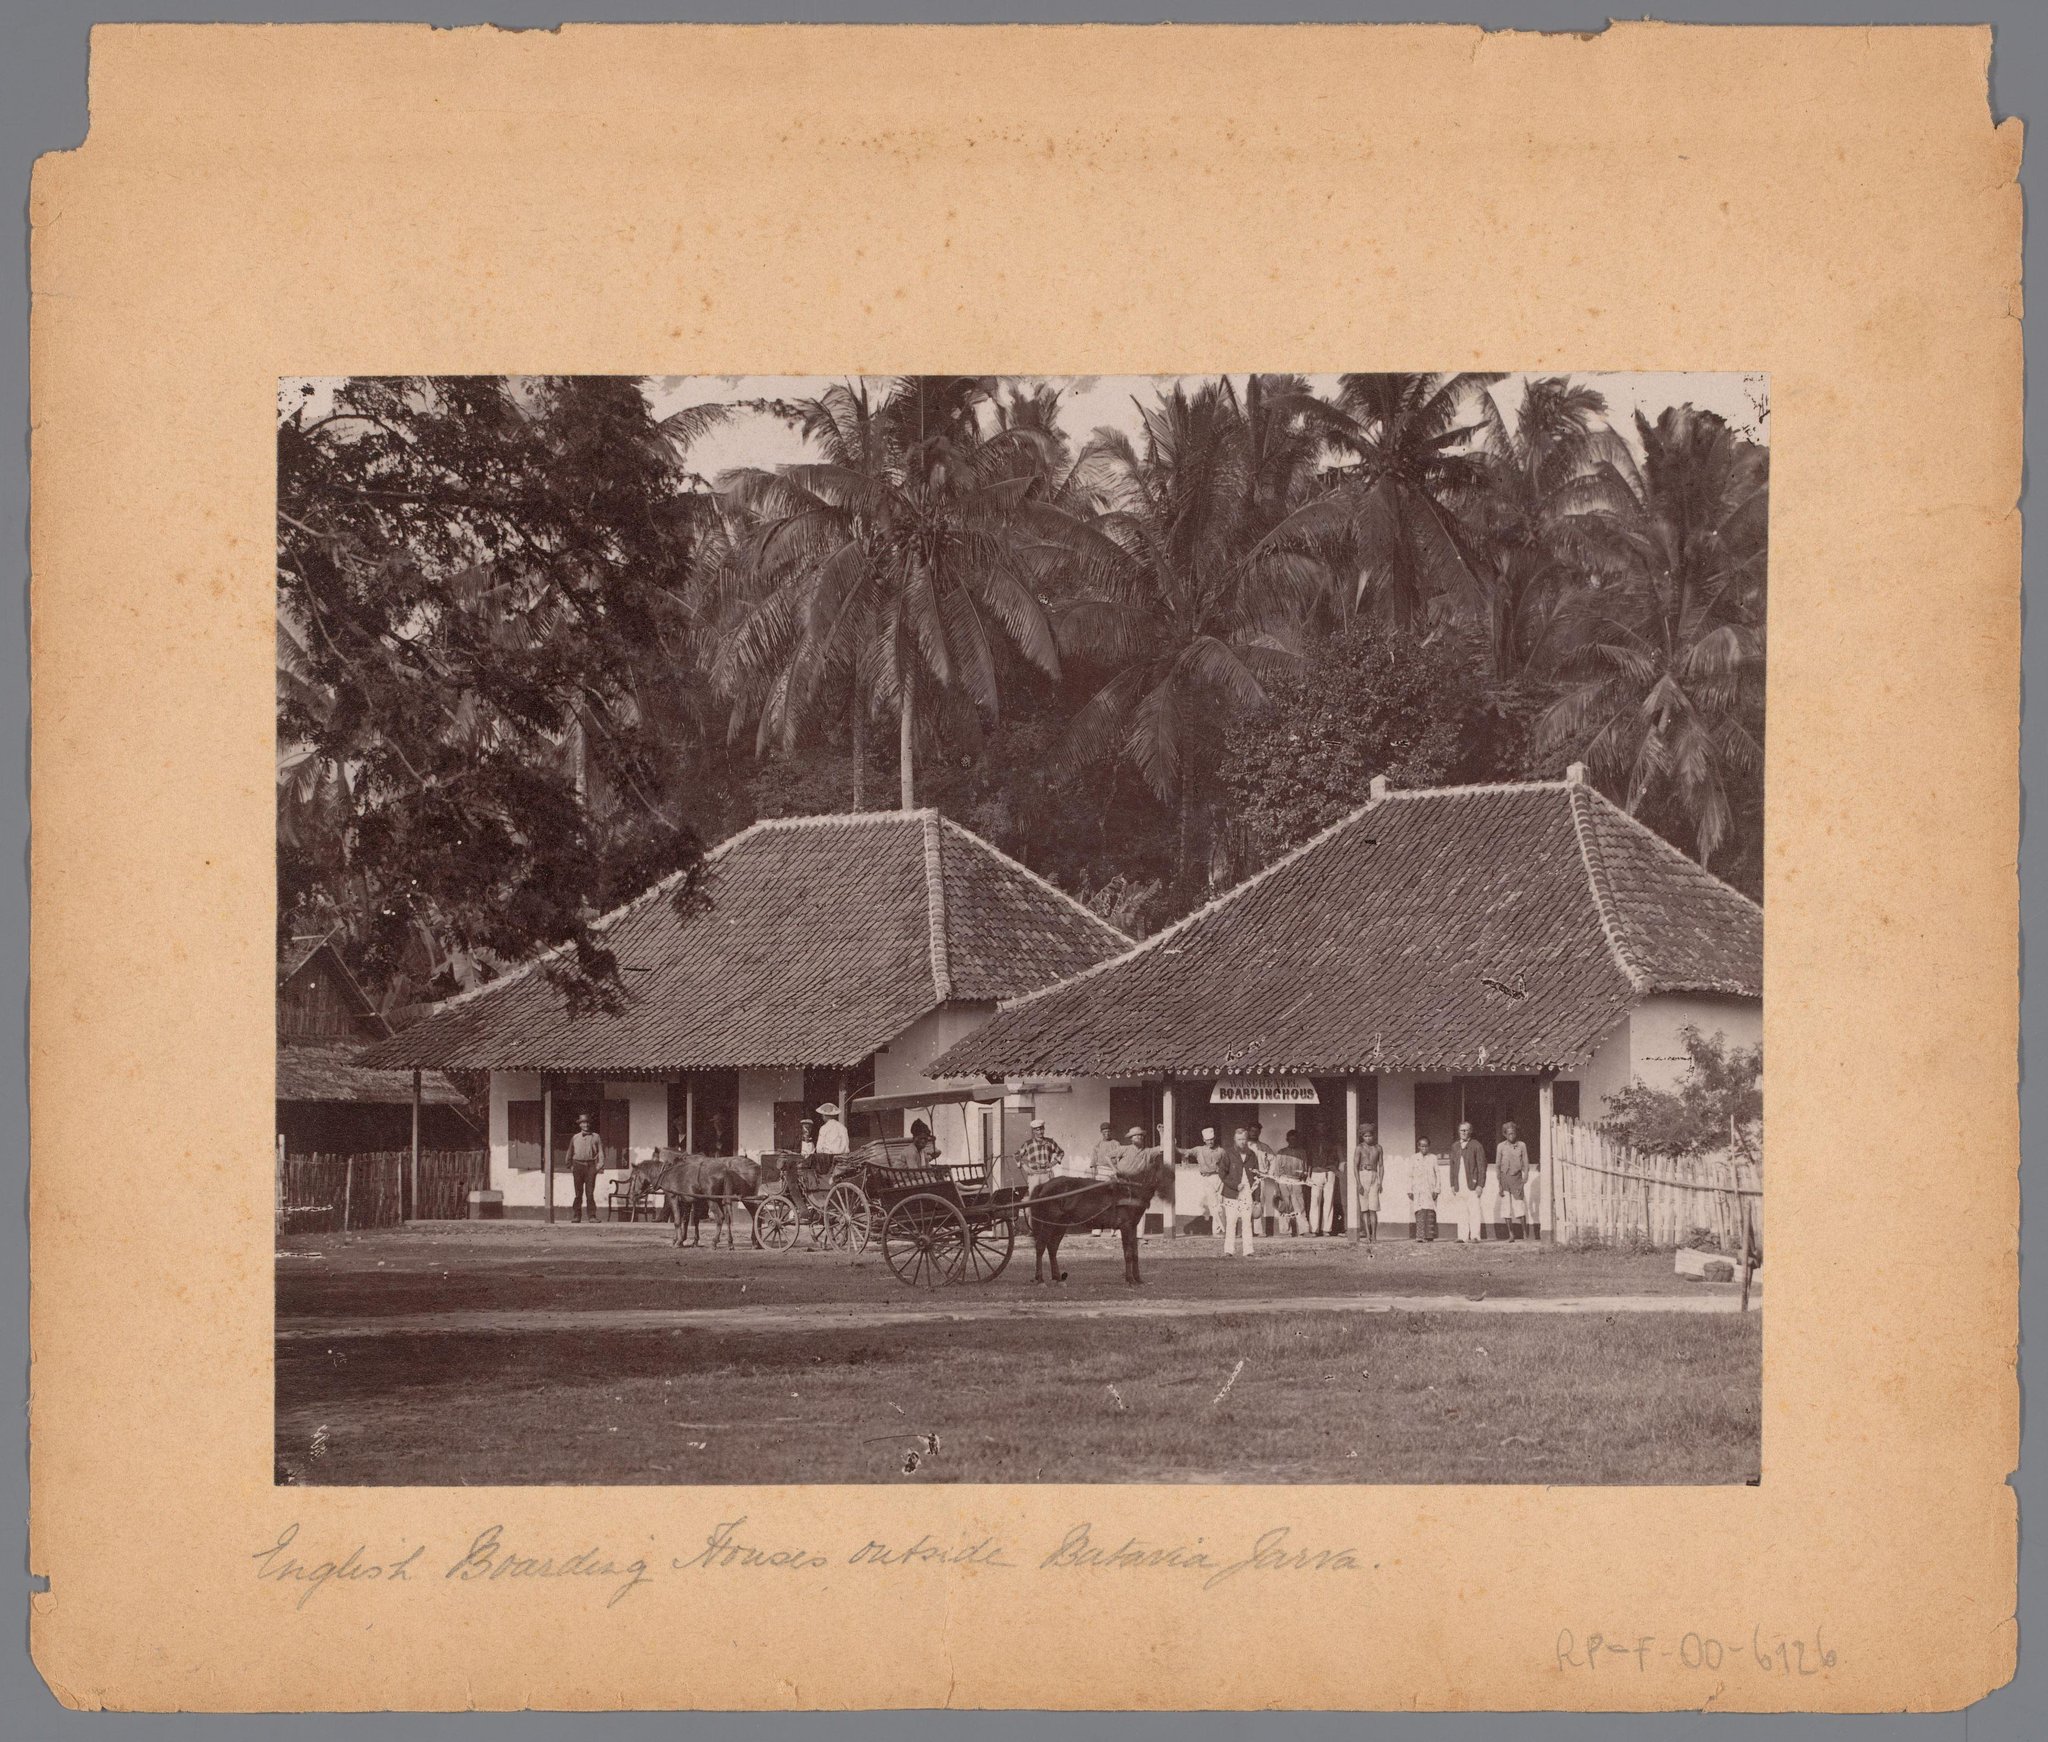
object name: photograph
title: Engelse boarding houses buiten Batavia (huidige Jakarta), Java, Nederlands-Indië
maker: Anonymous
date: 1900-1915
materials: cardboard, paper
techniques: gelatin silver print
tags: batavia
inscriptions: inscription: ‘English Boarding Houses outside Batavia Jarva. [sic]’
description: Engelse boarding houses buiten Batavia, Java, Nederlands-Indië. Boven de ingang van een van de huizen hangt het bord: "W.J. Schinkel Boarding House". Voor de huizen staan paar en wagens en mensen te poseren. Op de achtergrond palmbomen. Mogelijk een albumblad.